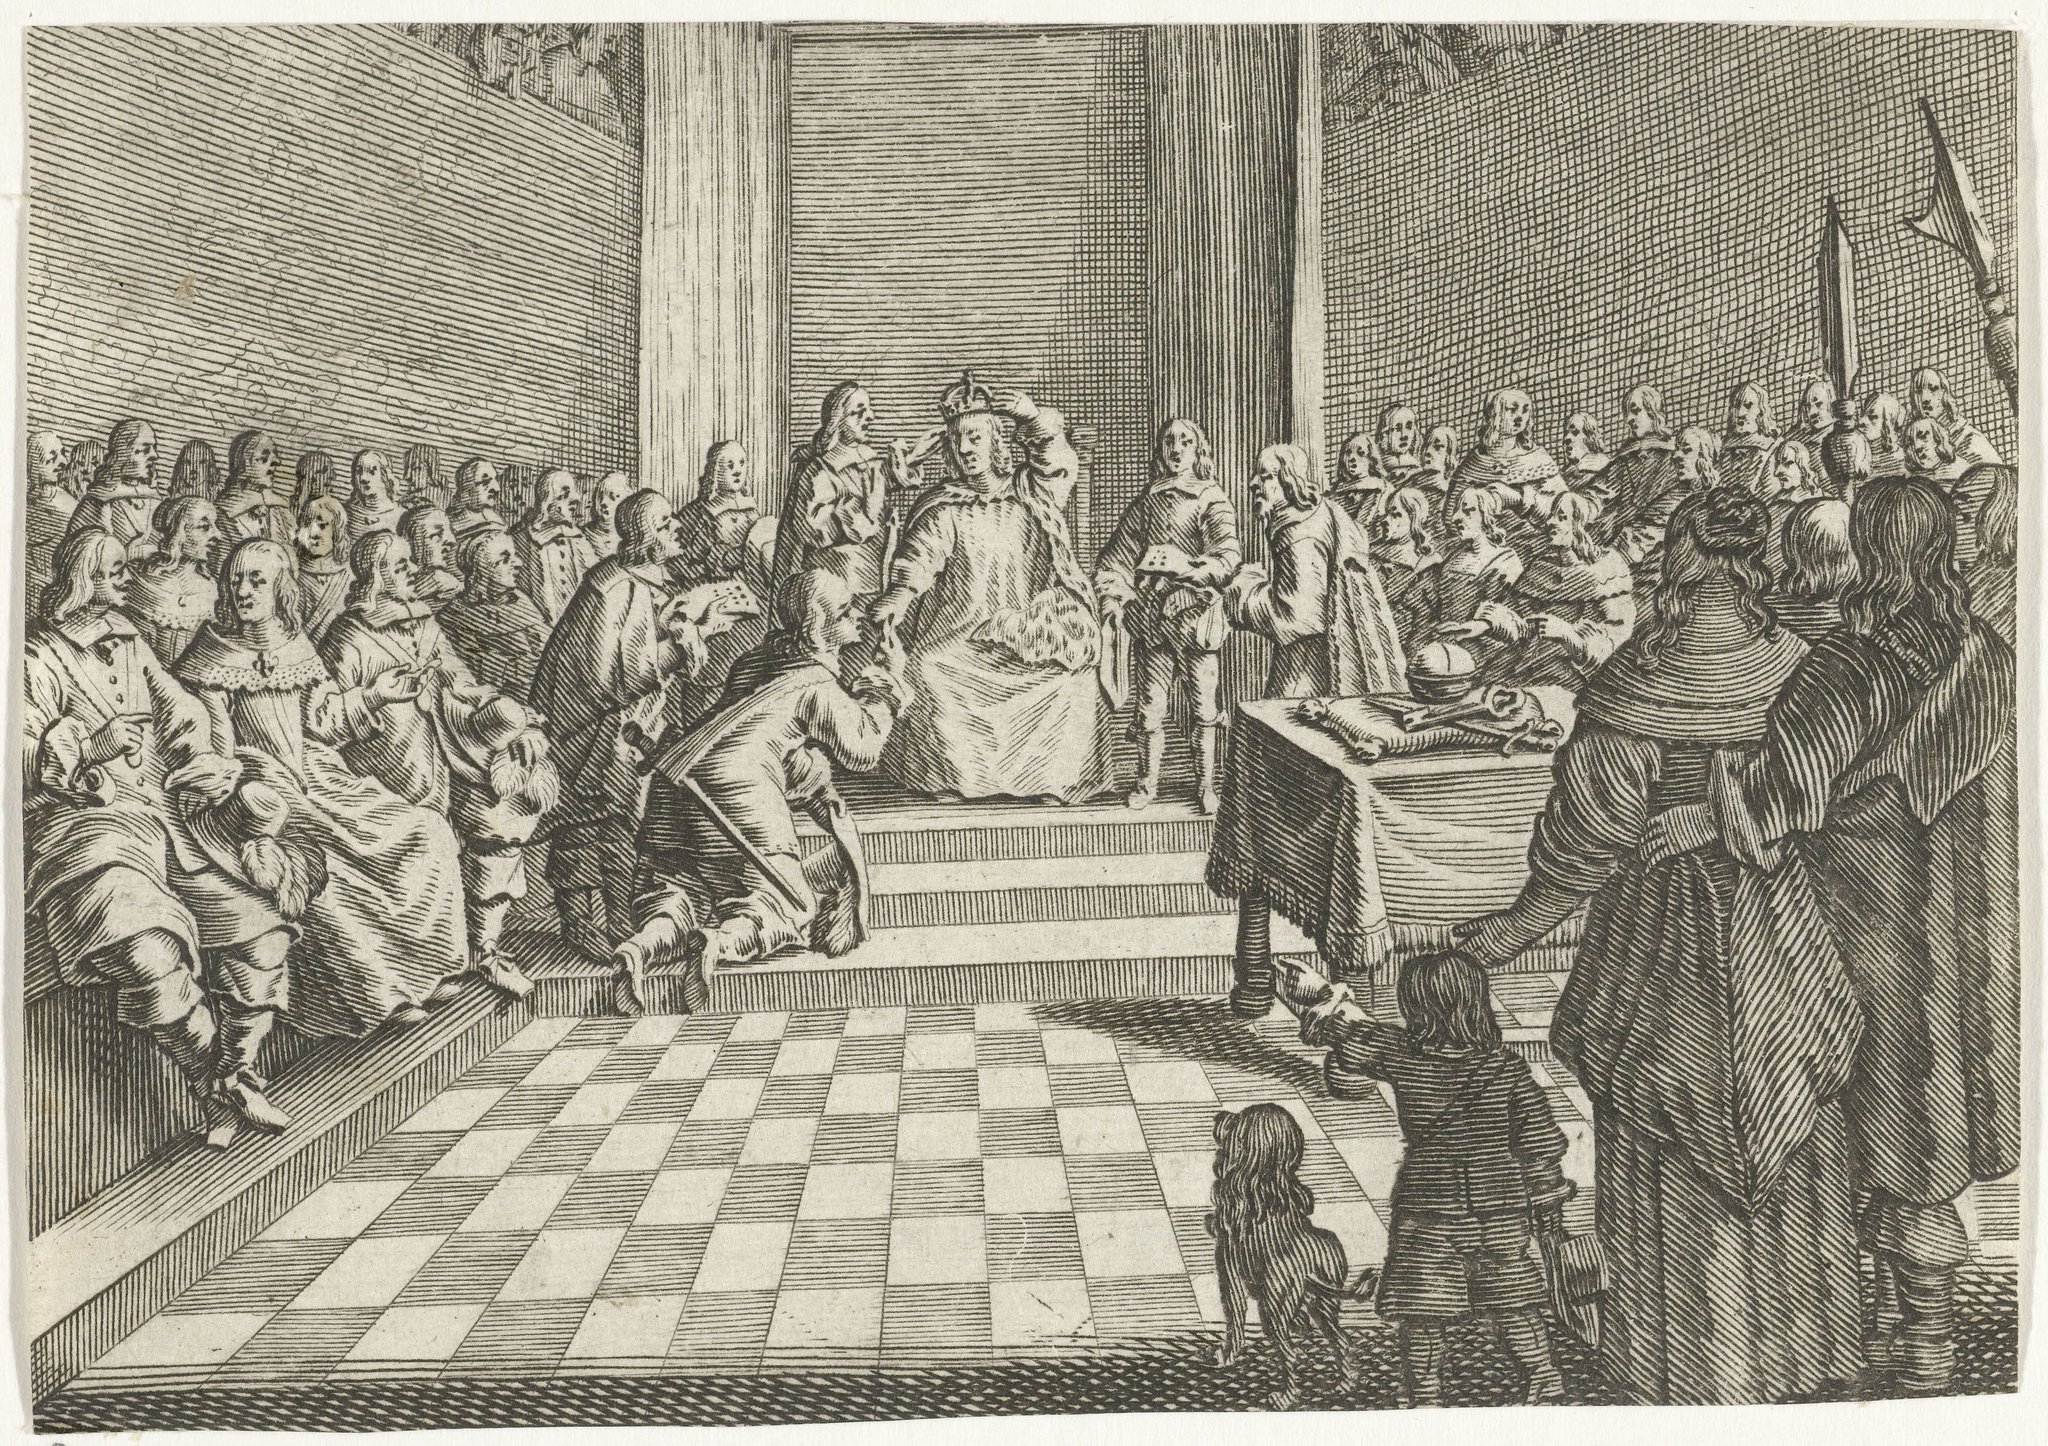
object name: print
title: Een kroning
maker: christiaan hagen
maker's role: draughtsman, print maker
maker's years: 1635-1707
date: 1663-1695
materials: paper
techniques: engraving, etching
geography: amsterdam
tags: kneeling figure, interior ~ representation of a building, index finger forwards, pointing, indicating, insignia and symbols of sovereignty (crown, diadem, sceptre, orb, seal, standard, cloak, pectoral), pavement, floor ~ architecture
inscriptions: collector's mark: Lugt 2228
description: Vele figuren in een interieur, waarin in het midden een man wordt gekroond. Zijn rechterhand wordt gekust door een knielende man. Links staat een tafel met daarop een zwaard, een sleutel en een rijksappel. Op de voorgrond een wijzend kind en een hond.